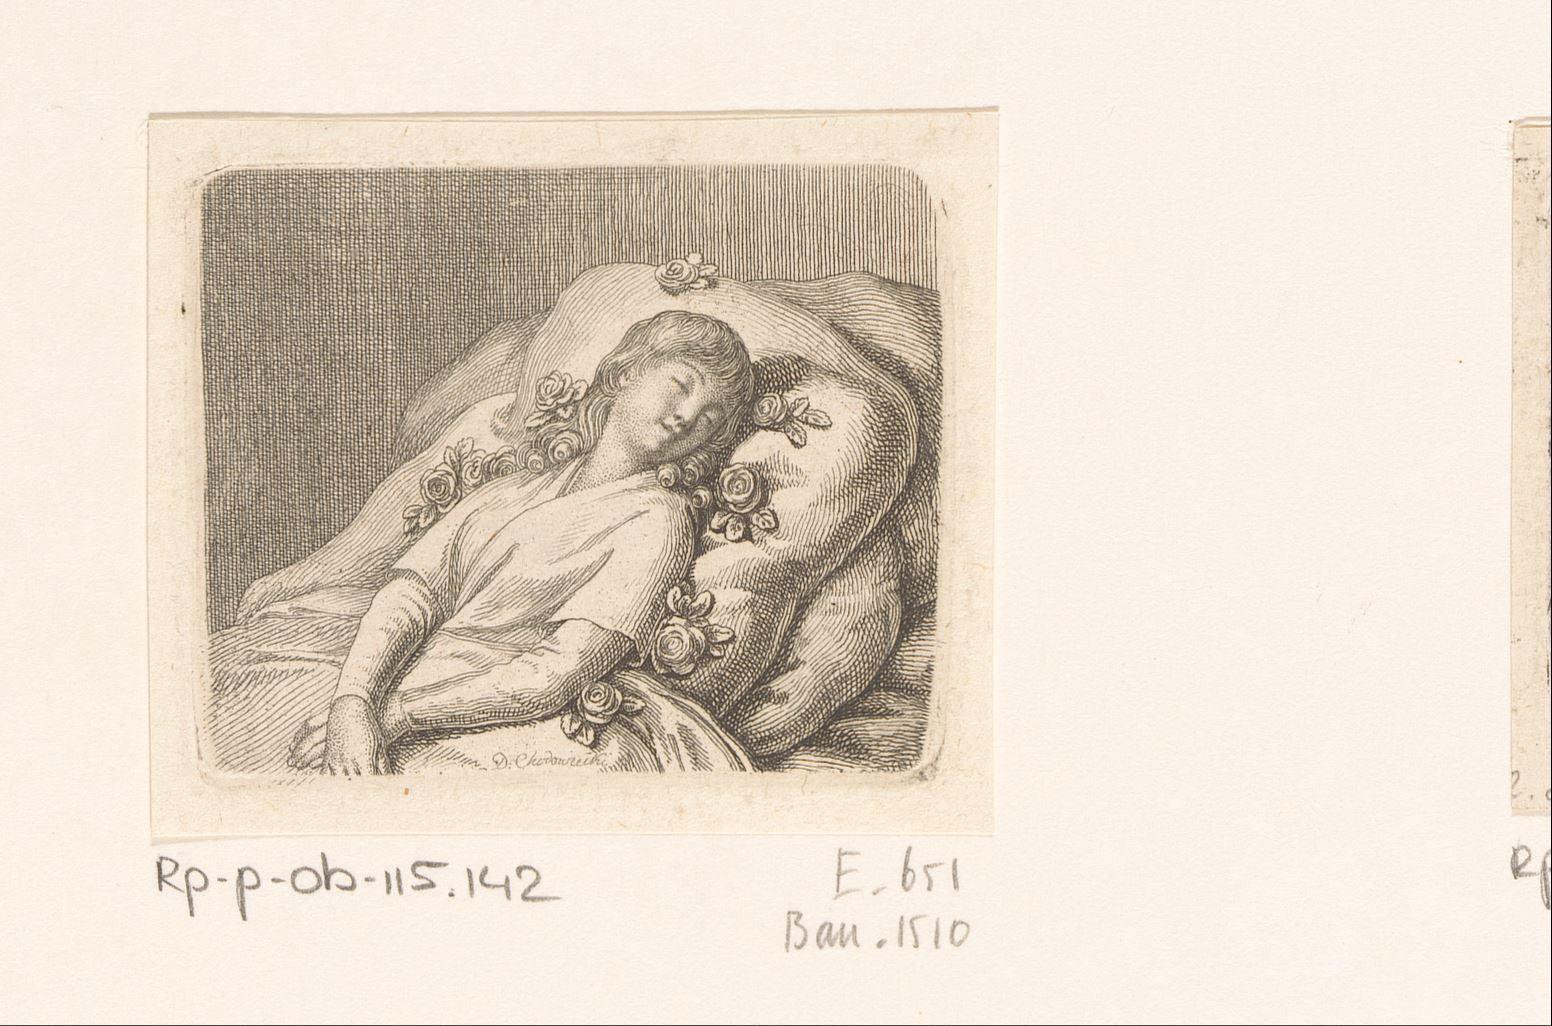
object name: print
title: Slapend meisje op een bed met rozen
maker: daniel nikolaus chodowiecki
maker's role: draughtsman, print maker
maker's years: 1726-1801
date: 1790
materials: paper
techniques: etching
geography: berlin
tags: adolescent, young woman, maiden, sleeping in bed, flowers: rose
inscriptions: collector's mark: Lugt 2228